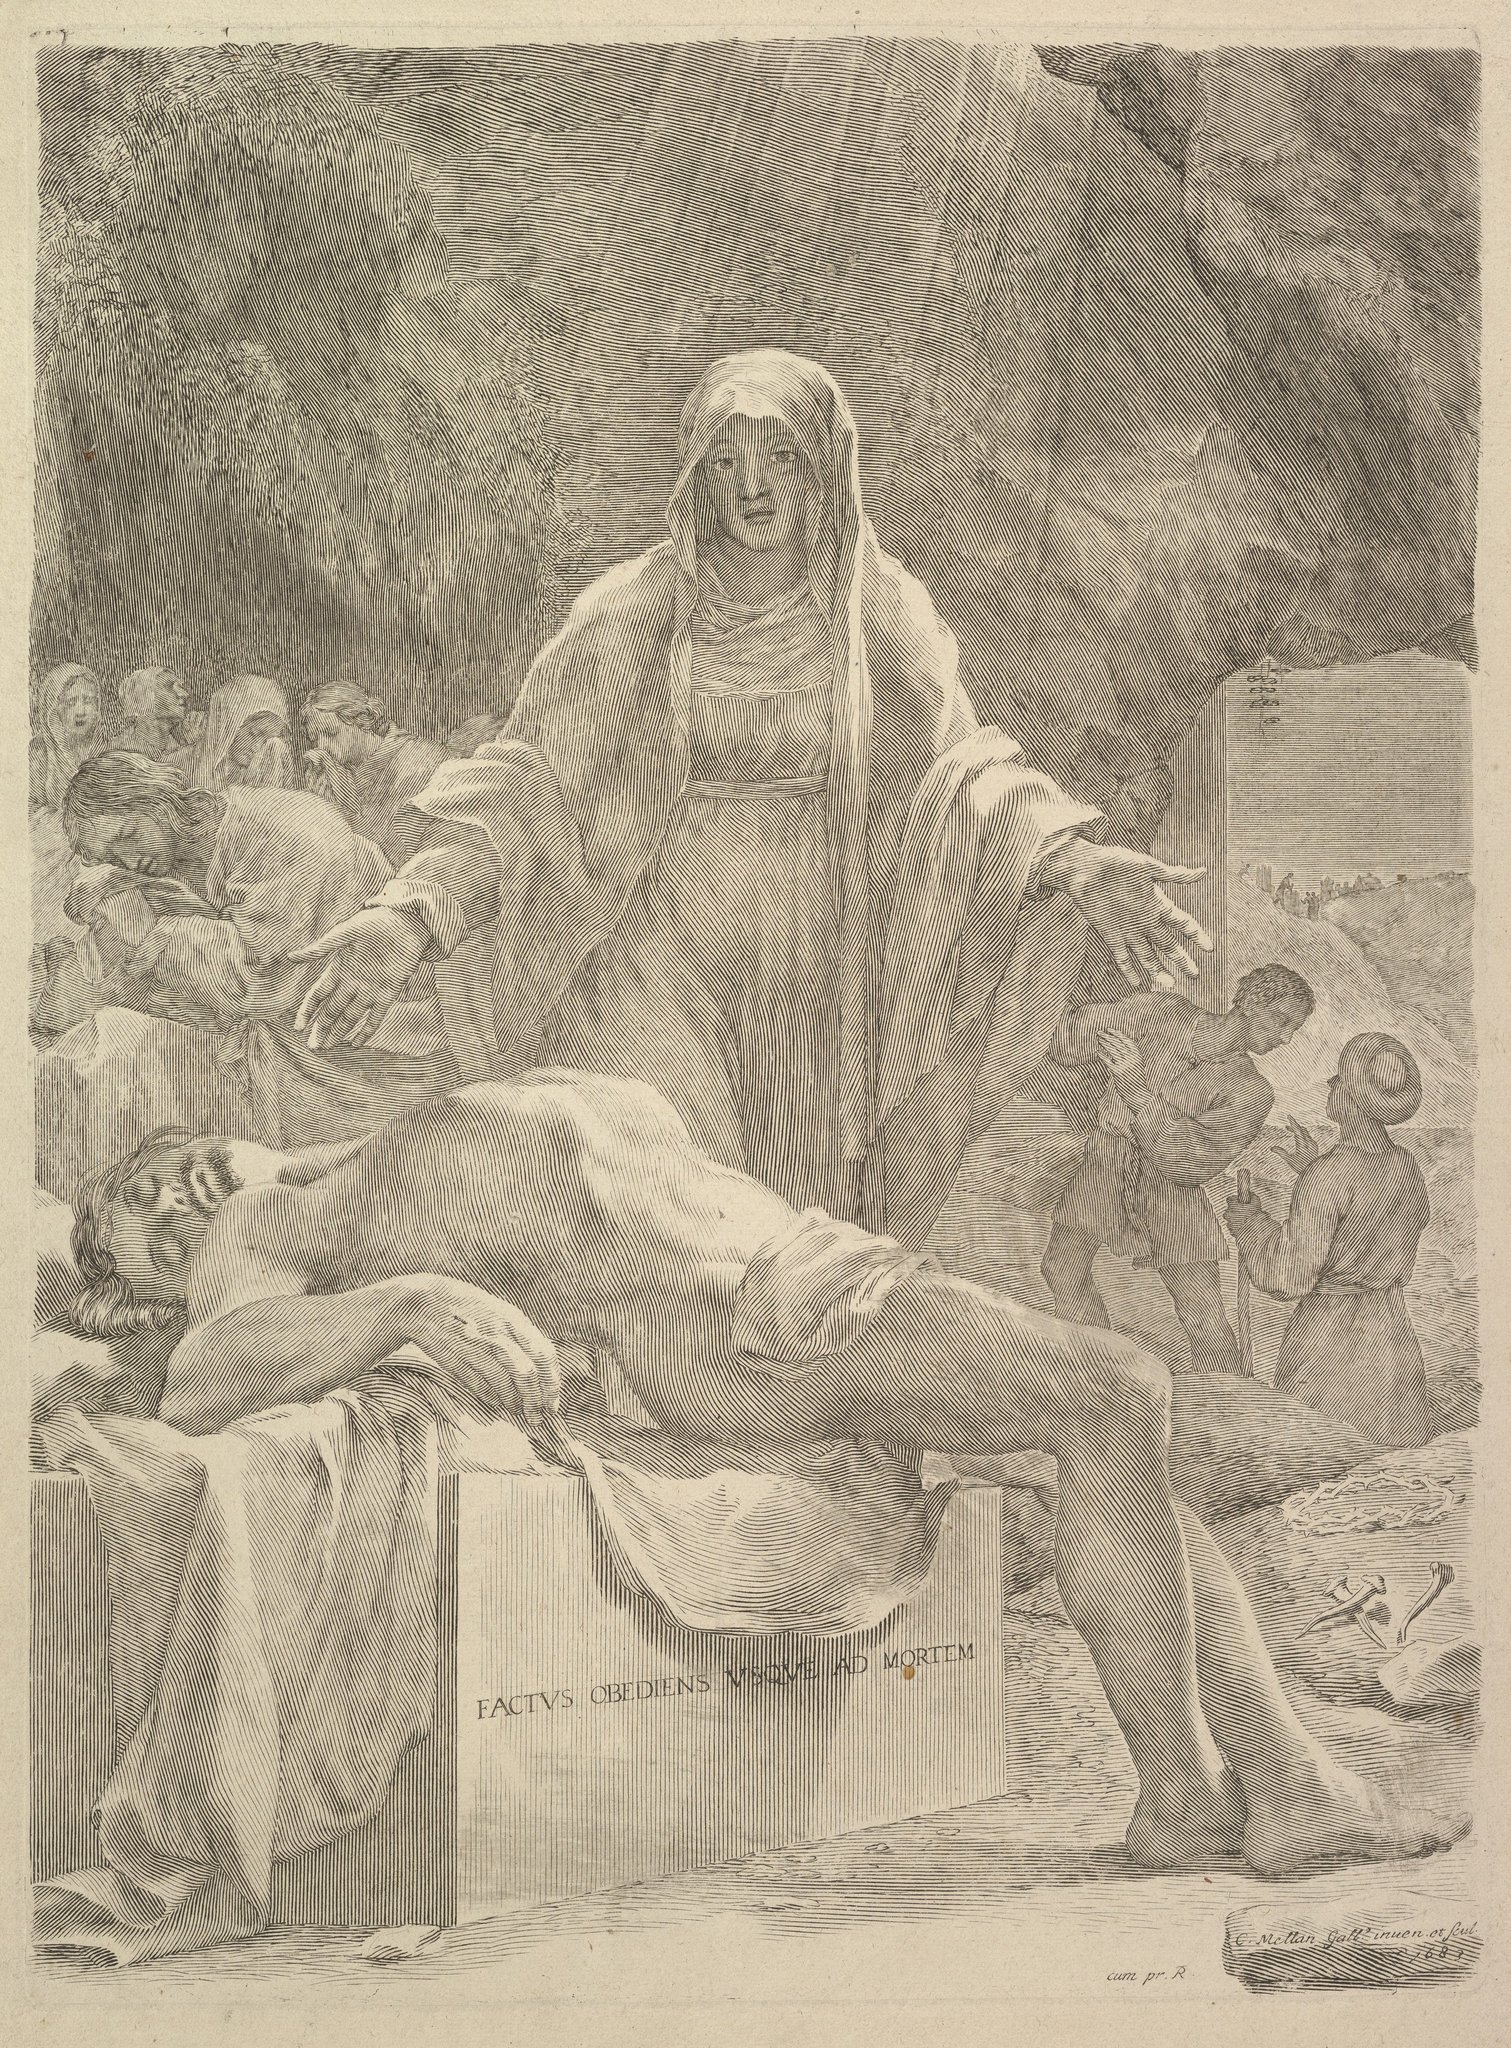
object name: print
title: Lamentation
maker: claude mellan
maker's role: artist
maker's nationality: french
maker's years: 1598-1688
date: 1683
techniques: engraving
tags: sadness,suffering,christ,mary magdalene,virgin mary,lamentation,death